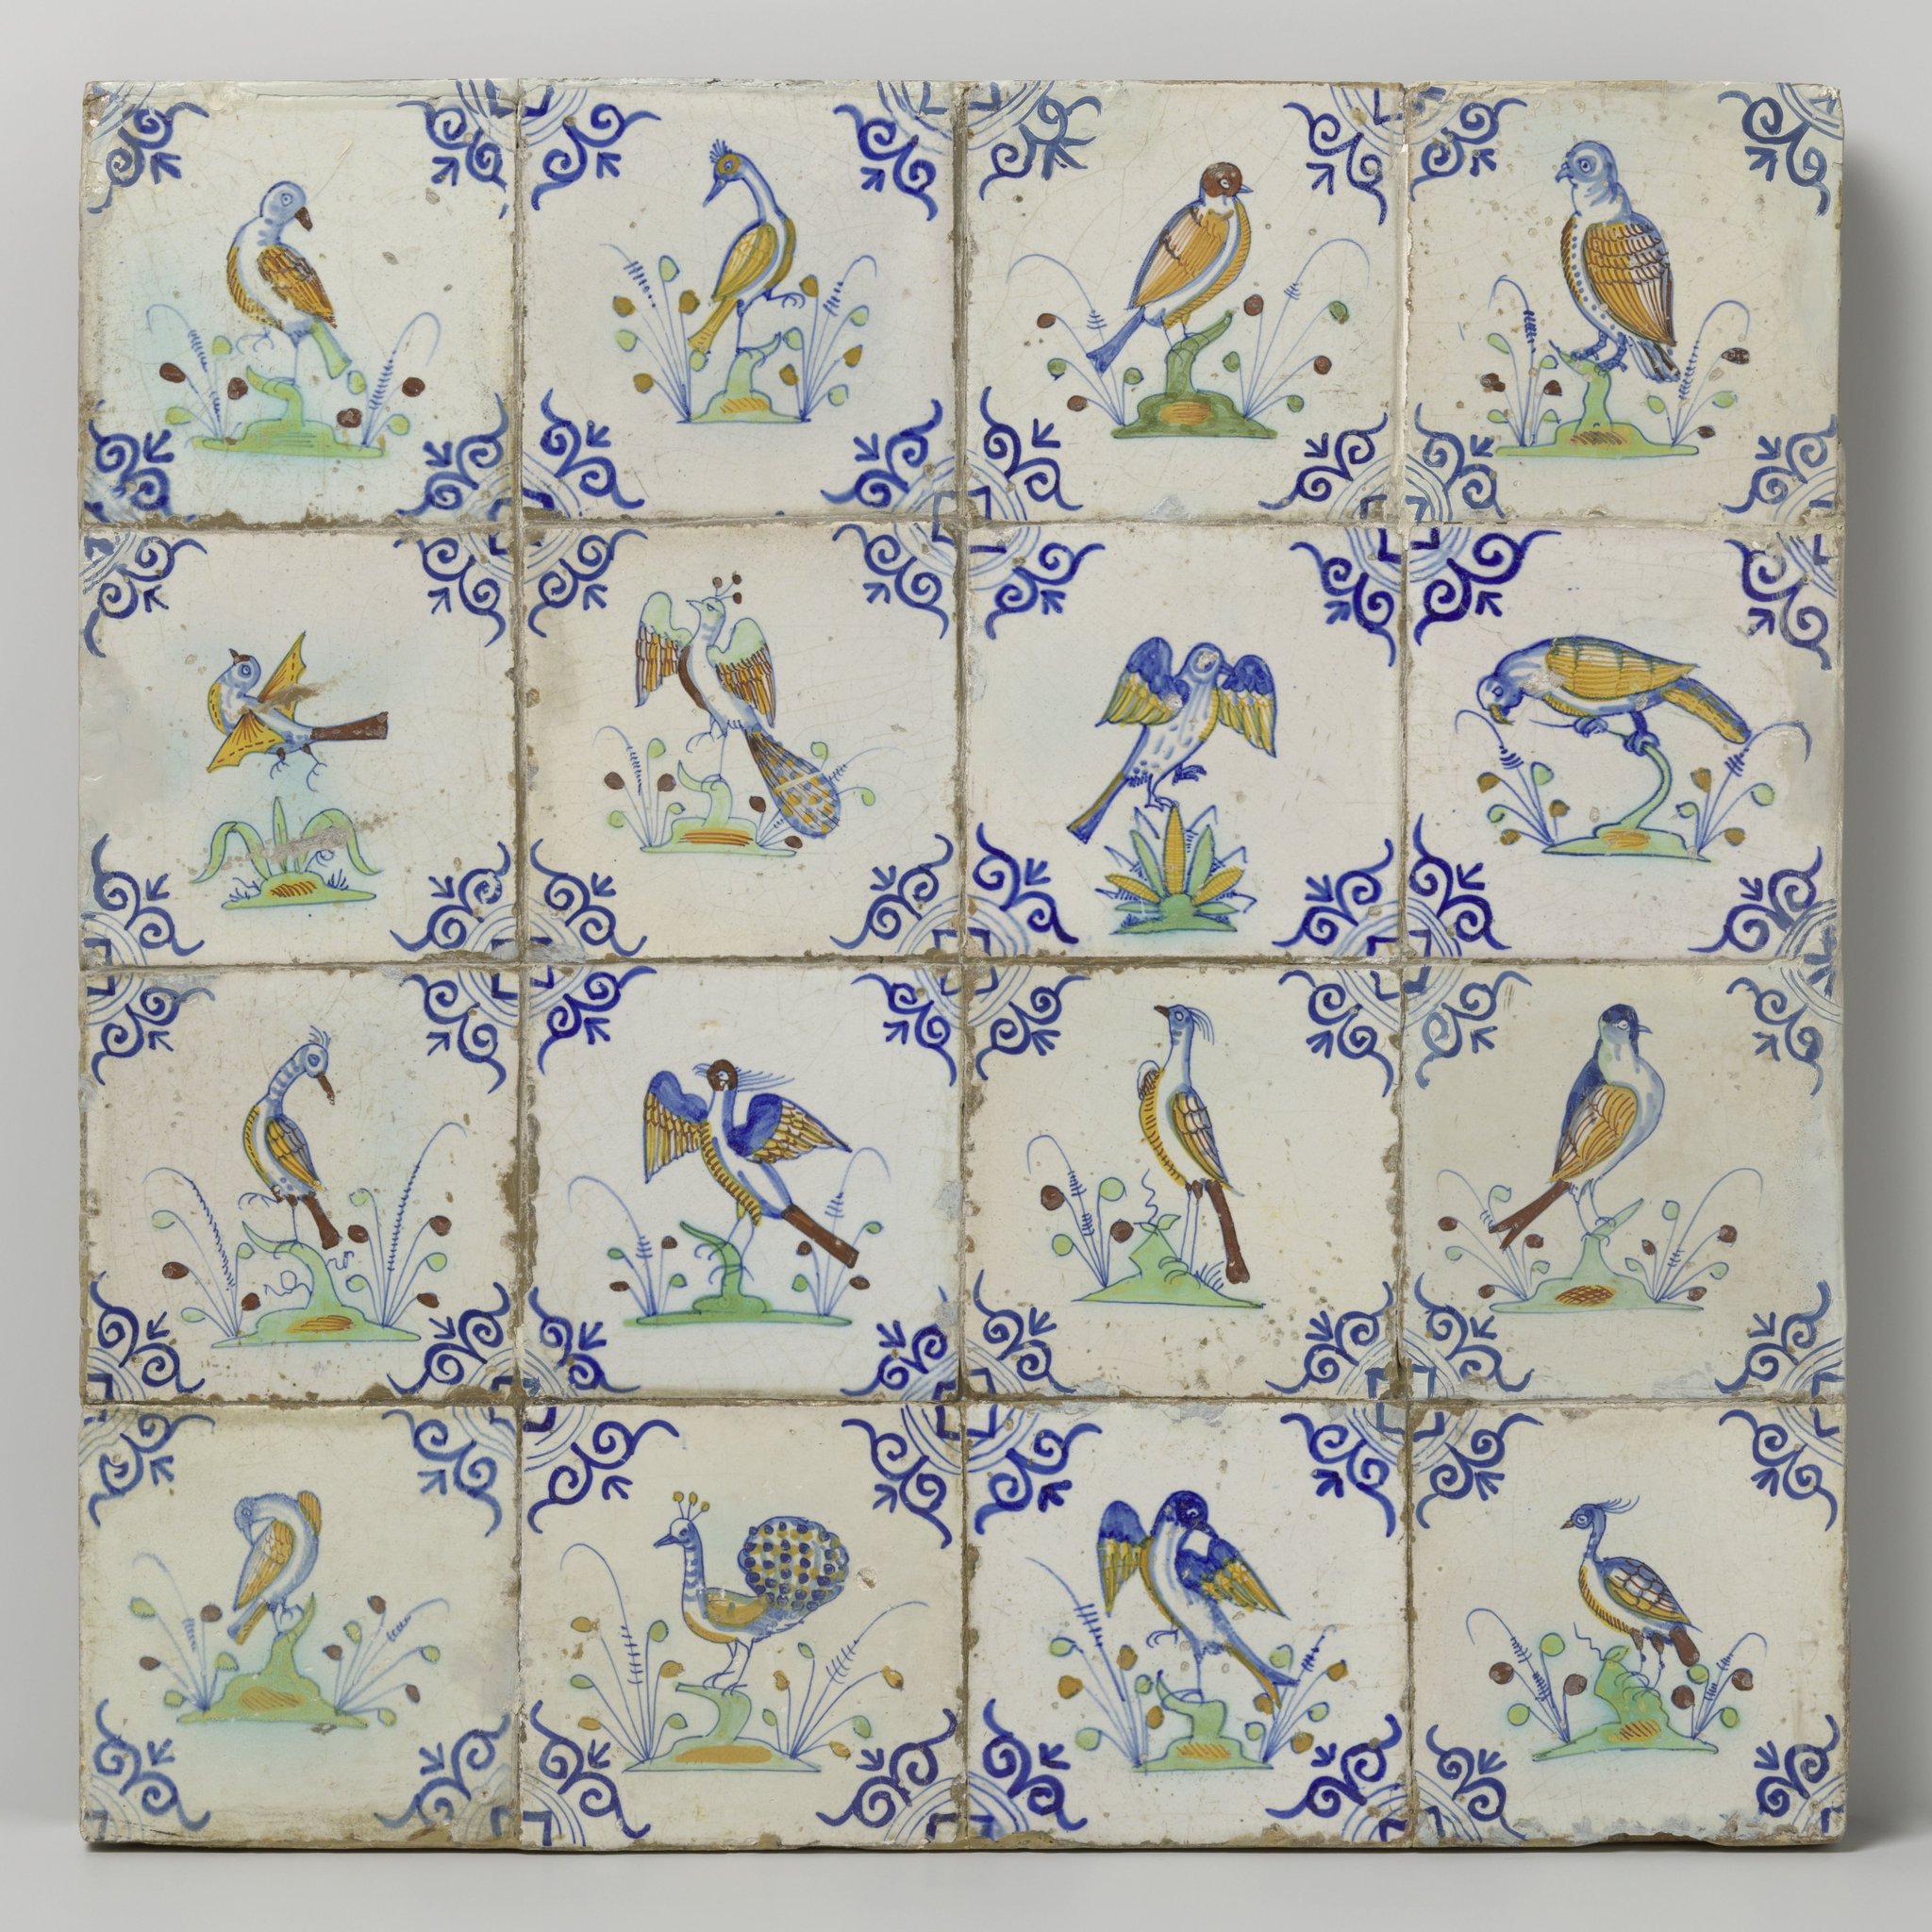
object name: tegelveld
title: Veld van zestien tegels met vogels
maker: Anonymous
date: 1640-1660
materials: earthenware, glaze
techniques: maiolica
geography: netherlands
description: Veld van zestien tegels (4 x 4) elk met een veelkleurige (blauw, groen, geel, oranje en paars) vogel op een grond met bessen. In de hoeken, een ossekop.